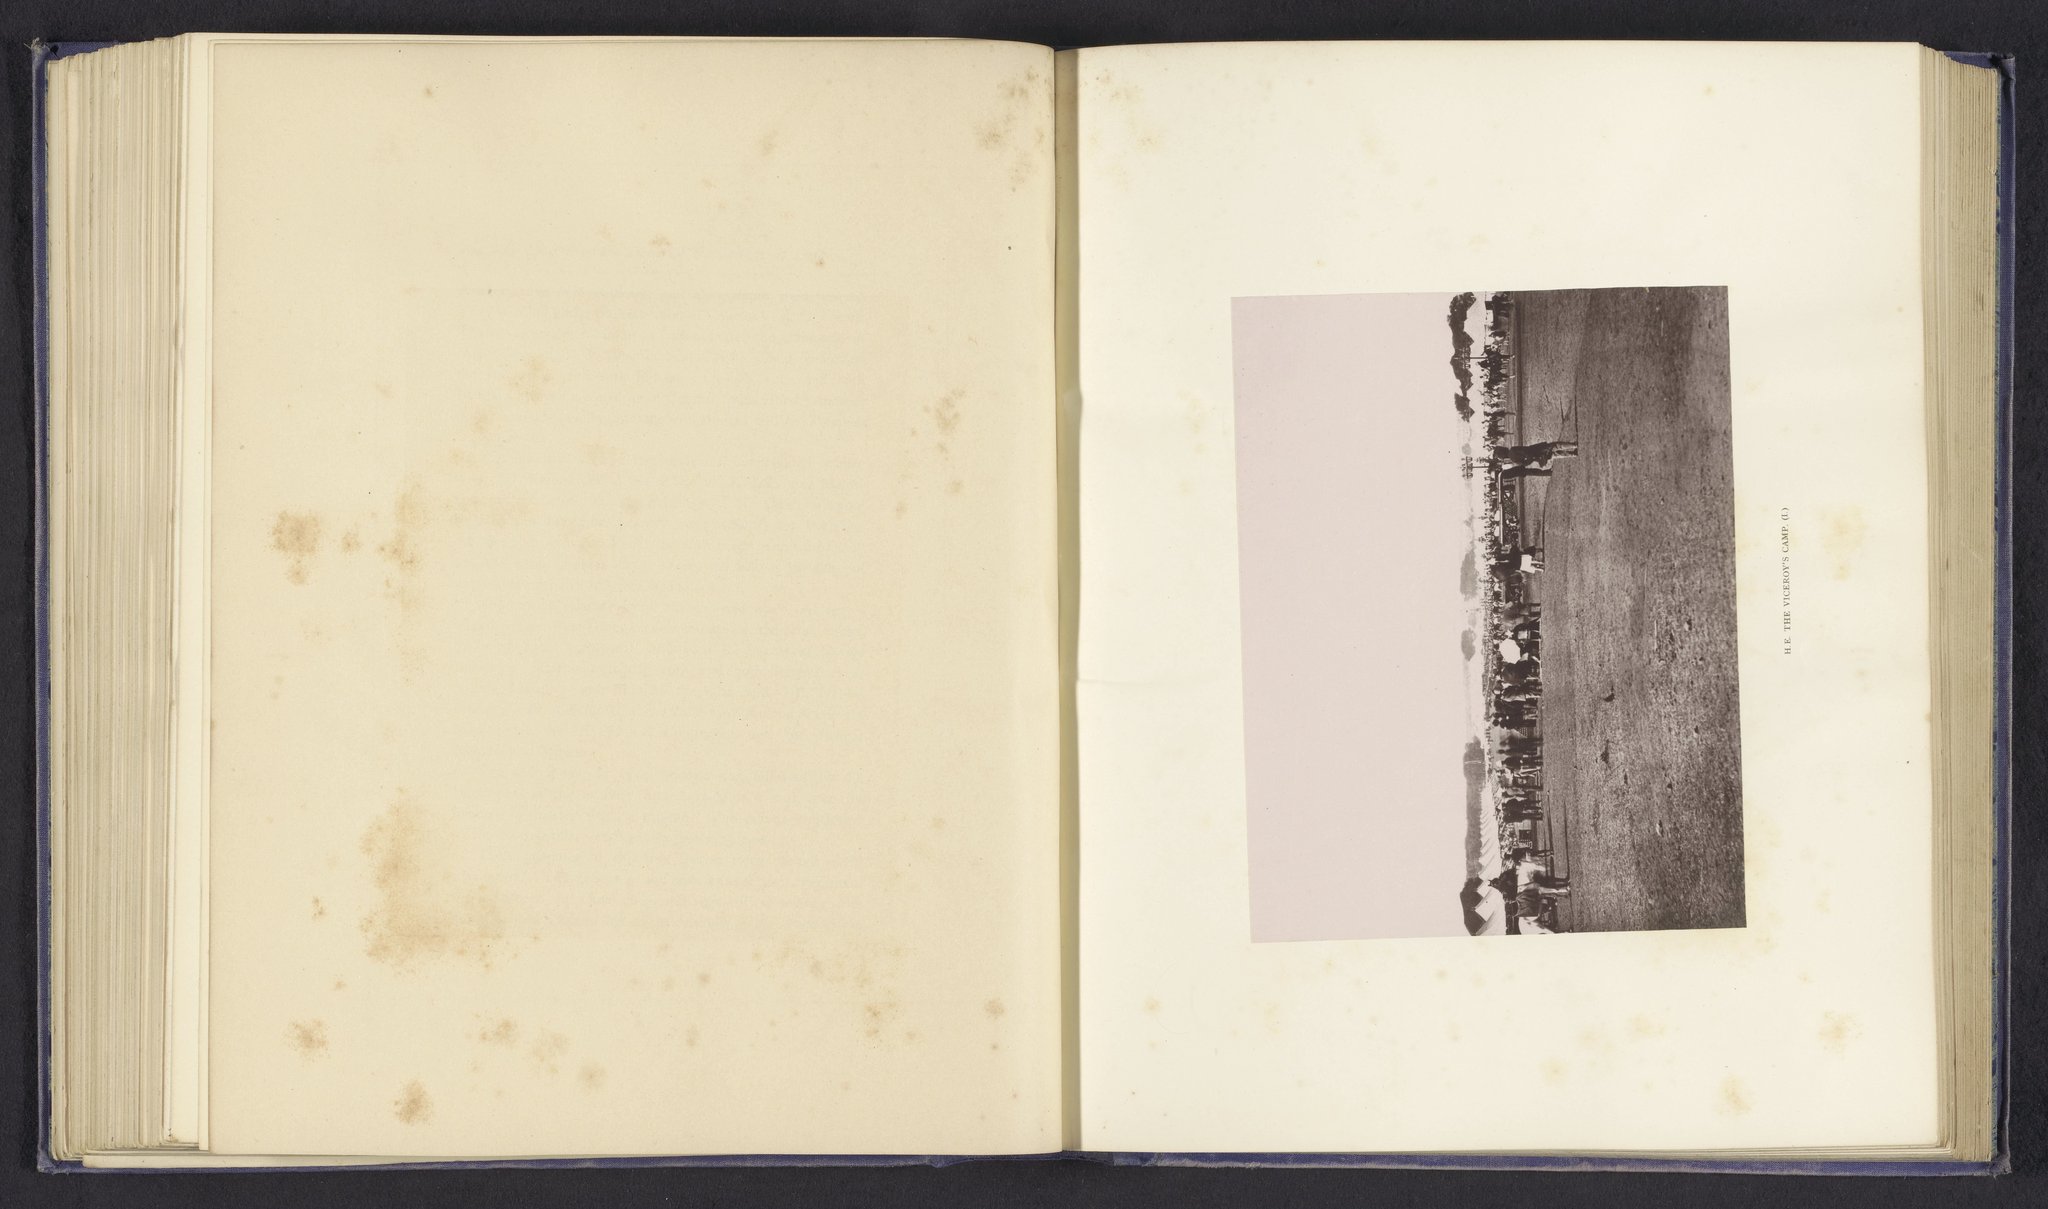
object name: page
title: Legerkamp van vermoedelijk Robert Bulwer-Lytton in Delhi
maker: Anonymous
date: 1876-1877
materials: paper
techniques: woodburytype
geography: delhi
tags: (military) camp with tents